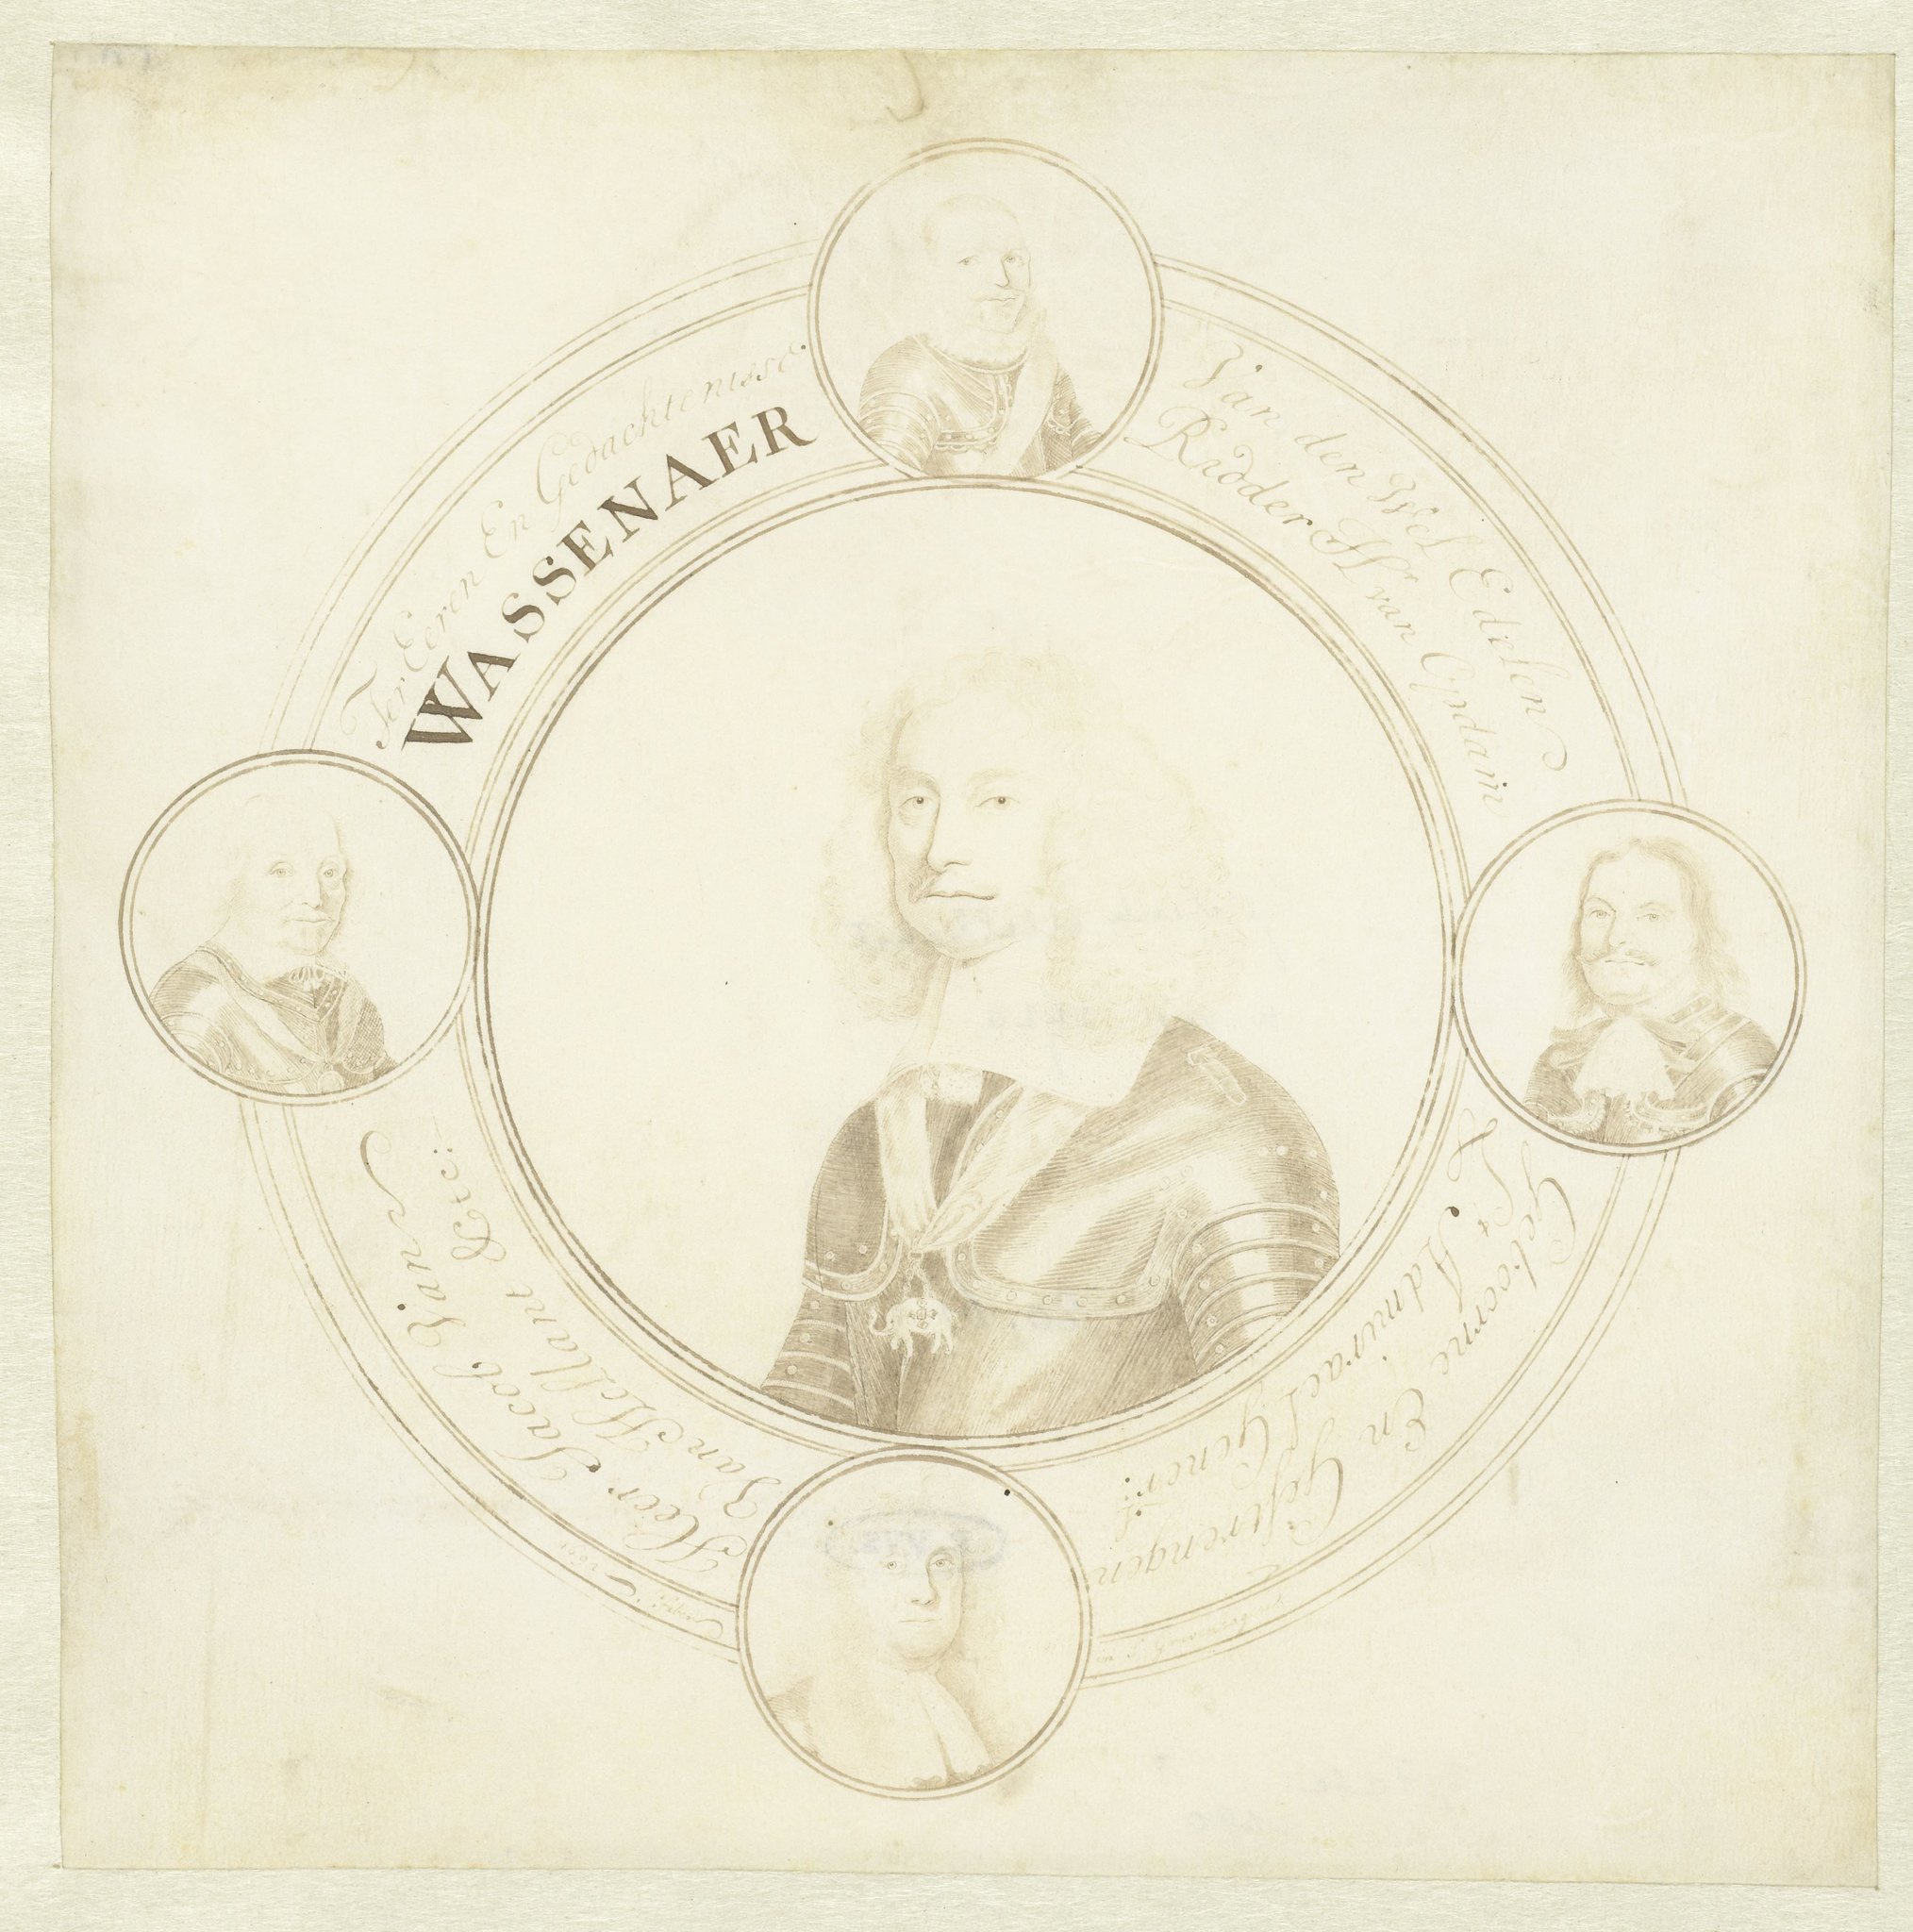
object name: drawing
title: Portret van Jacob van Wassenaer van Obdam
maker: john faber (i)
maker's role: draughtsman, print maker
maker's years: 1650-1721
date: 1692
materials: ink, parchment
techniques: pen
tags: jacob baron van wassenaer heer van obdam, historical persons